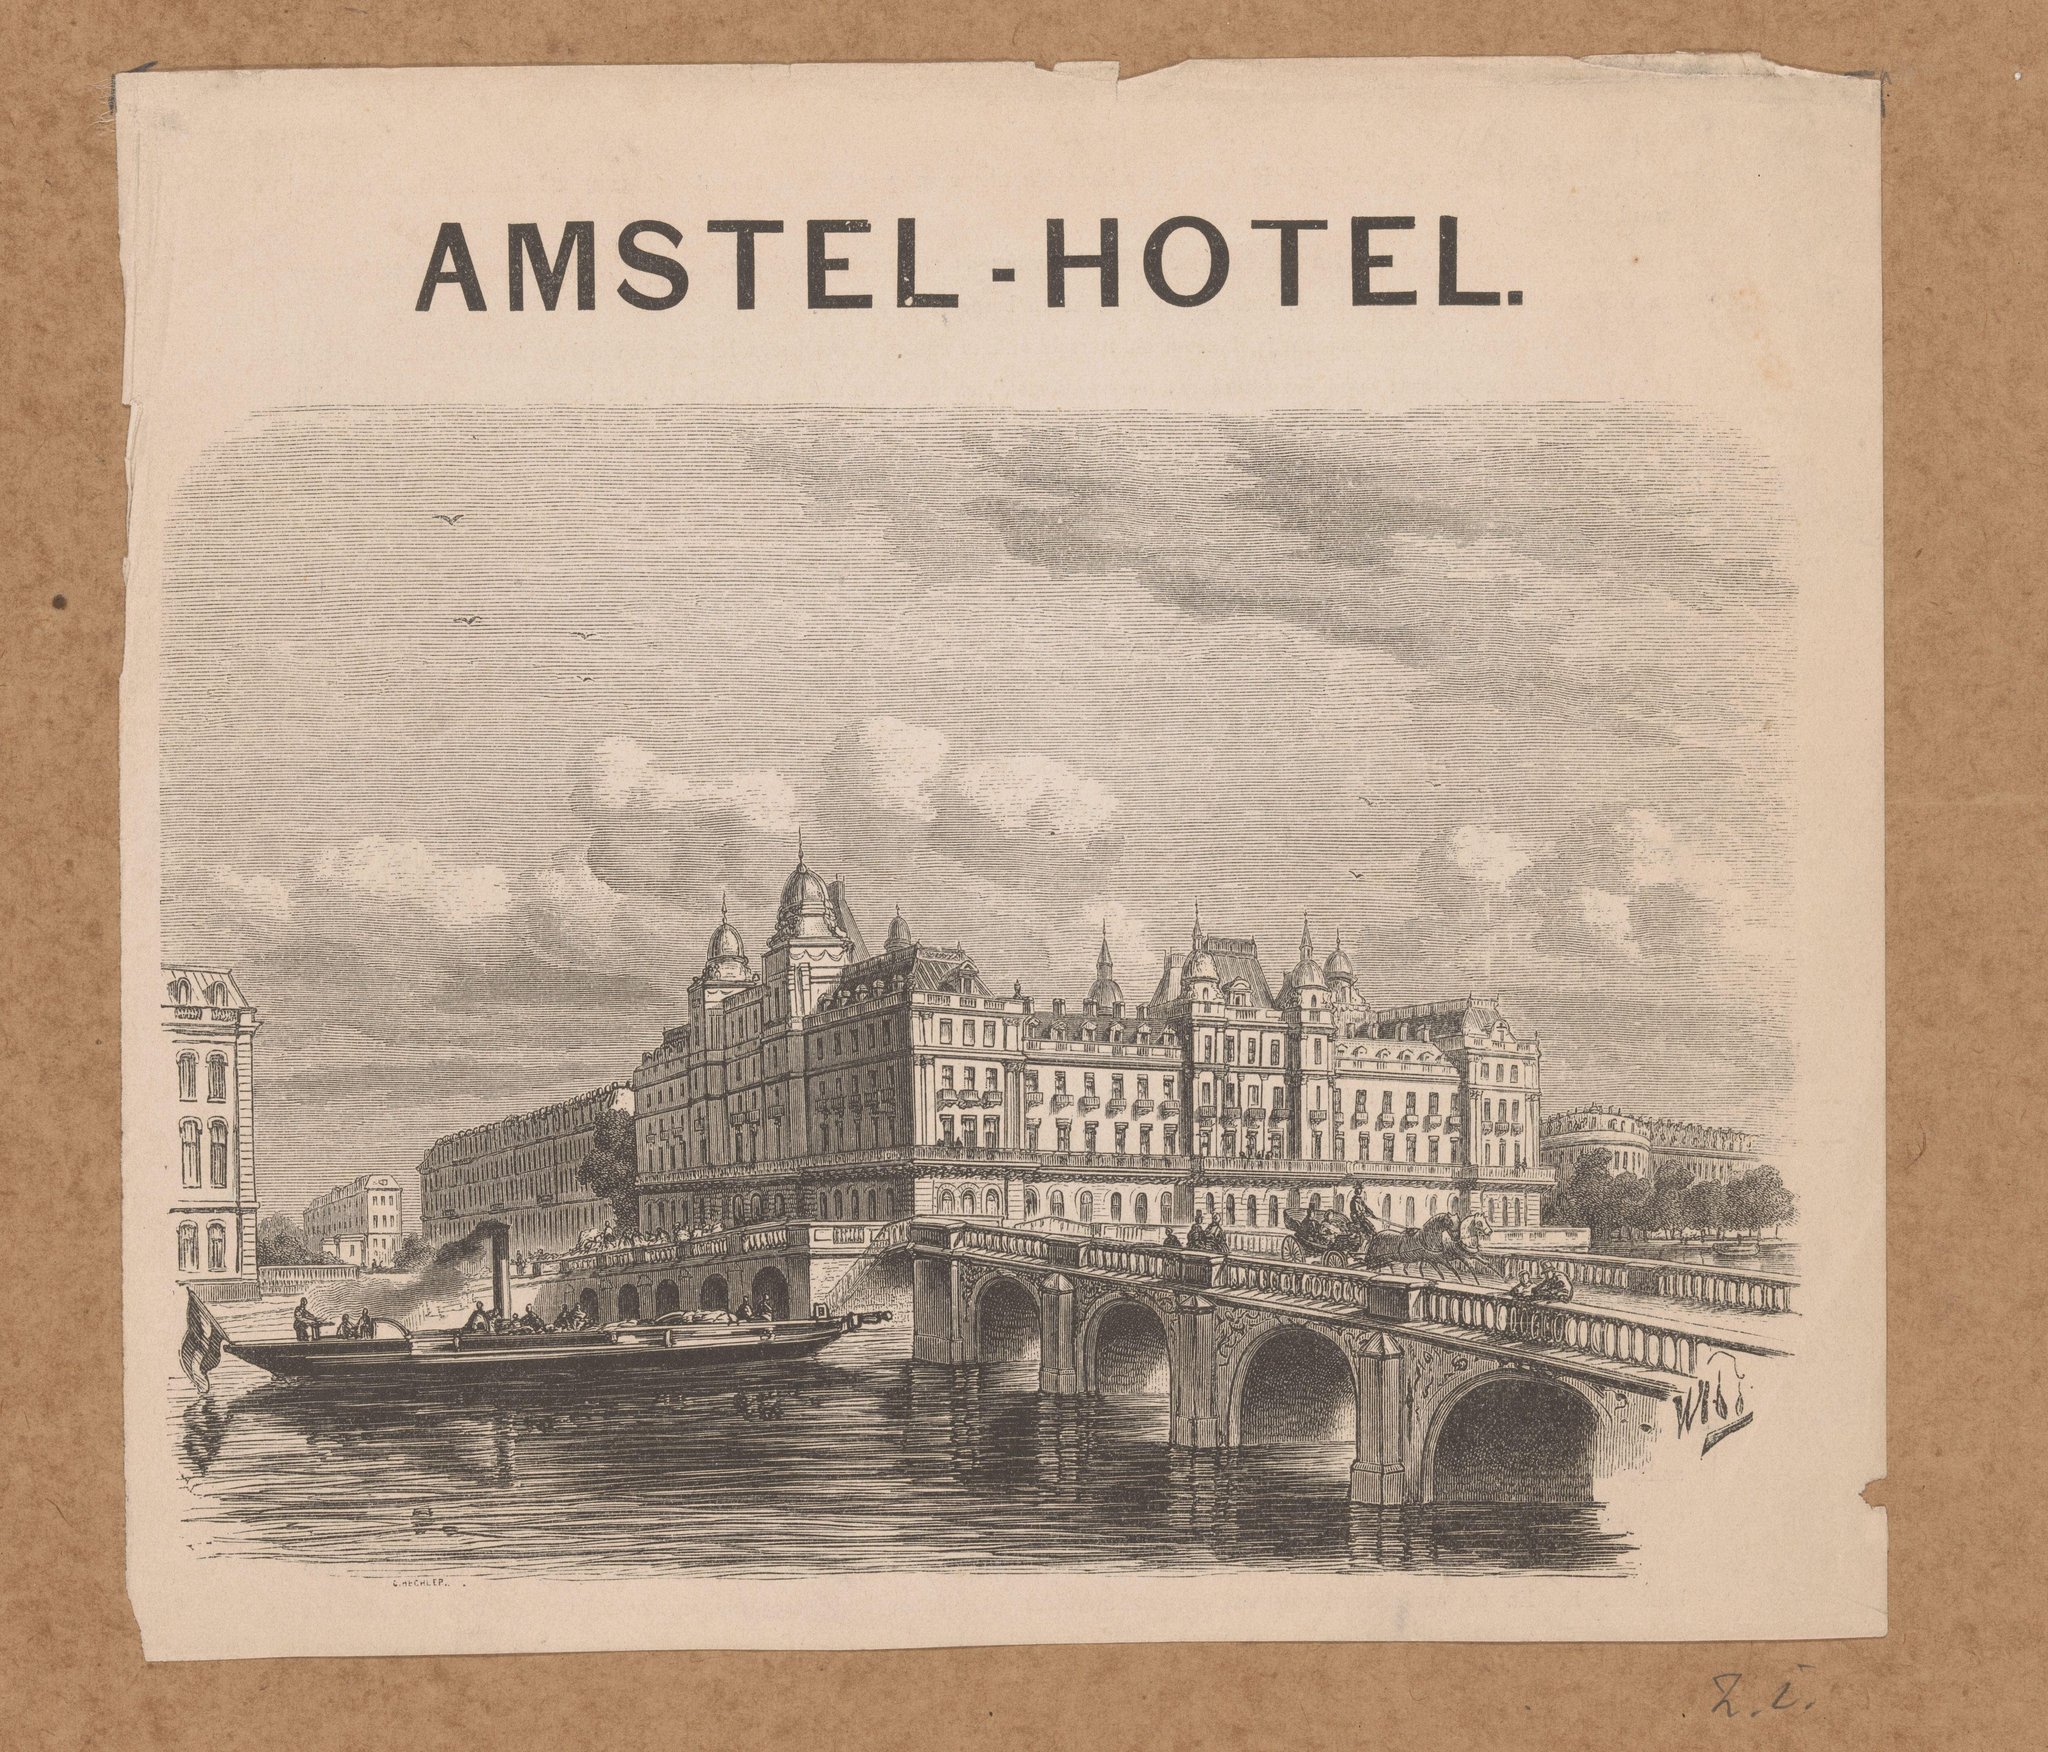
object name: book illustration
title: Amstel-Hotel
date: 1812-1865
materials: paper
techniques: letterpress printing, engraving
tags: bridge in city across river, canal, etc., four-wheeled vehicle drawn by two animals, hotel, hostelry, inn, steamship, motorship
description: Fragment van het prospectus en inschrijvingsformulier voor een investeringsmaatschappij om geld op te halen voor de bouw van het Amstel Hotel te Amsterdam, december 1865. Origineel een dubbelgevouwen blad bedrukt op alle zijden met op de voorzijde een gezicht op het te verrijzen hotel, op de andere zijden een beschrijving van het project door Dr. S. Saphati (zie RP-P-OB-89.212 voor een volledig exemplaar).